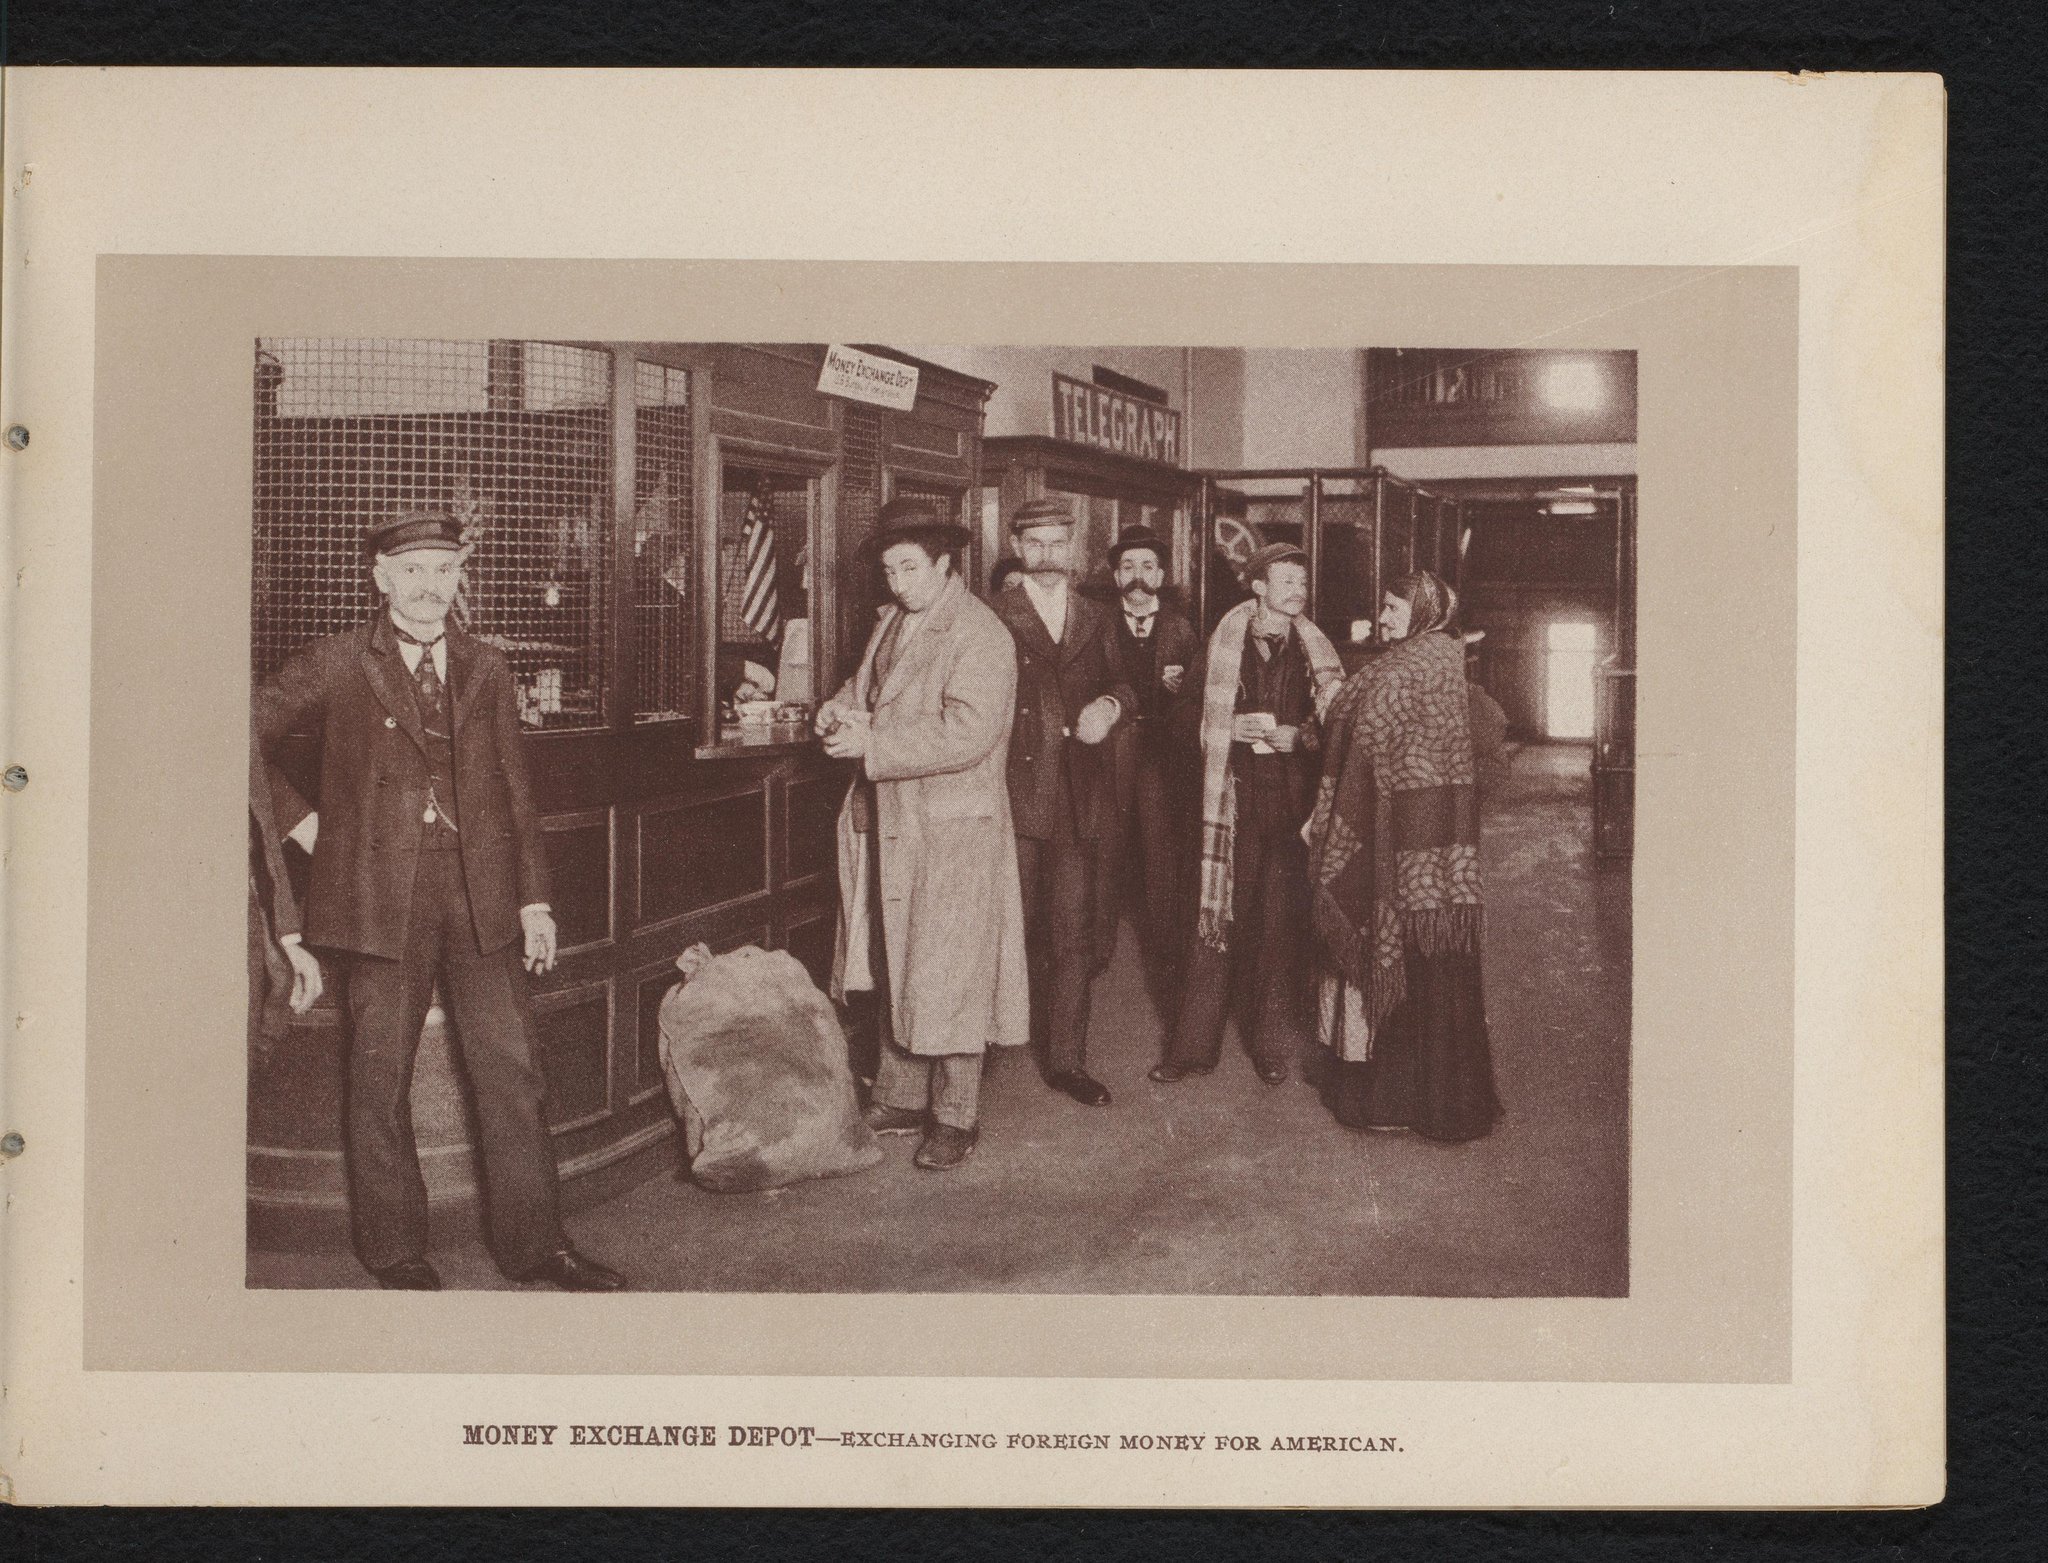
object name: photomechanical print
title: Migranten bij het geldwisselkantoor in New York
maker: Anonymous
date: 1897-1902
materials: paper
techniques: autotype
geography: new york city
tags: (descendants of) european emigrants to america, money, historical persons not known by name, new york (city)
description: Prent op zesentwintigste ongenummerde pagina.